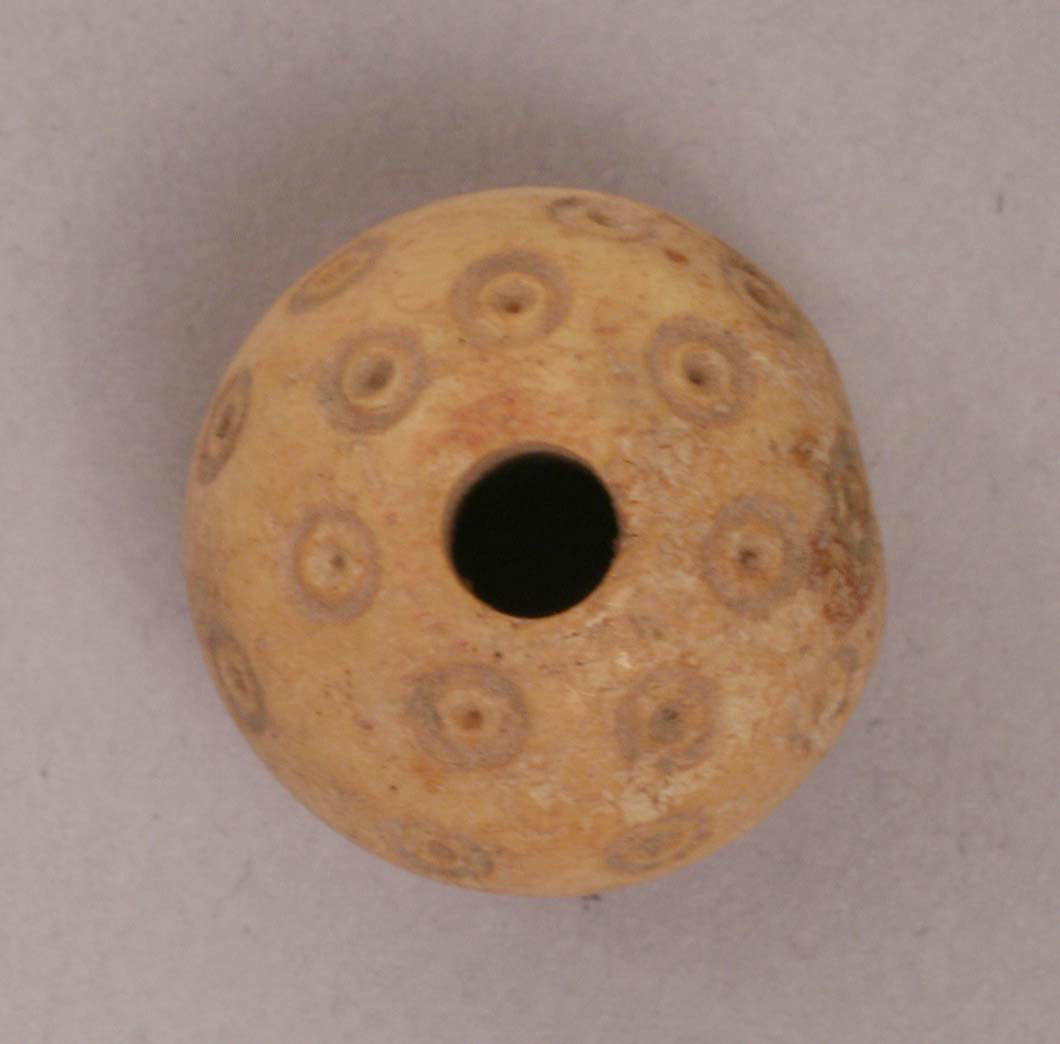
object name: button or bead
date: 801-1000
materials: bone, paint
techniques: incising, inlay, tinting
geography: iran